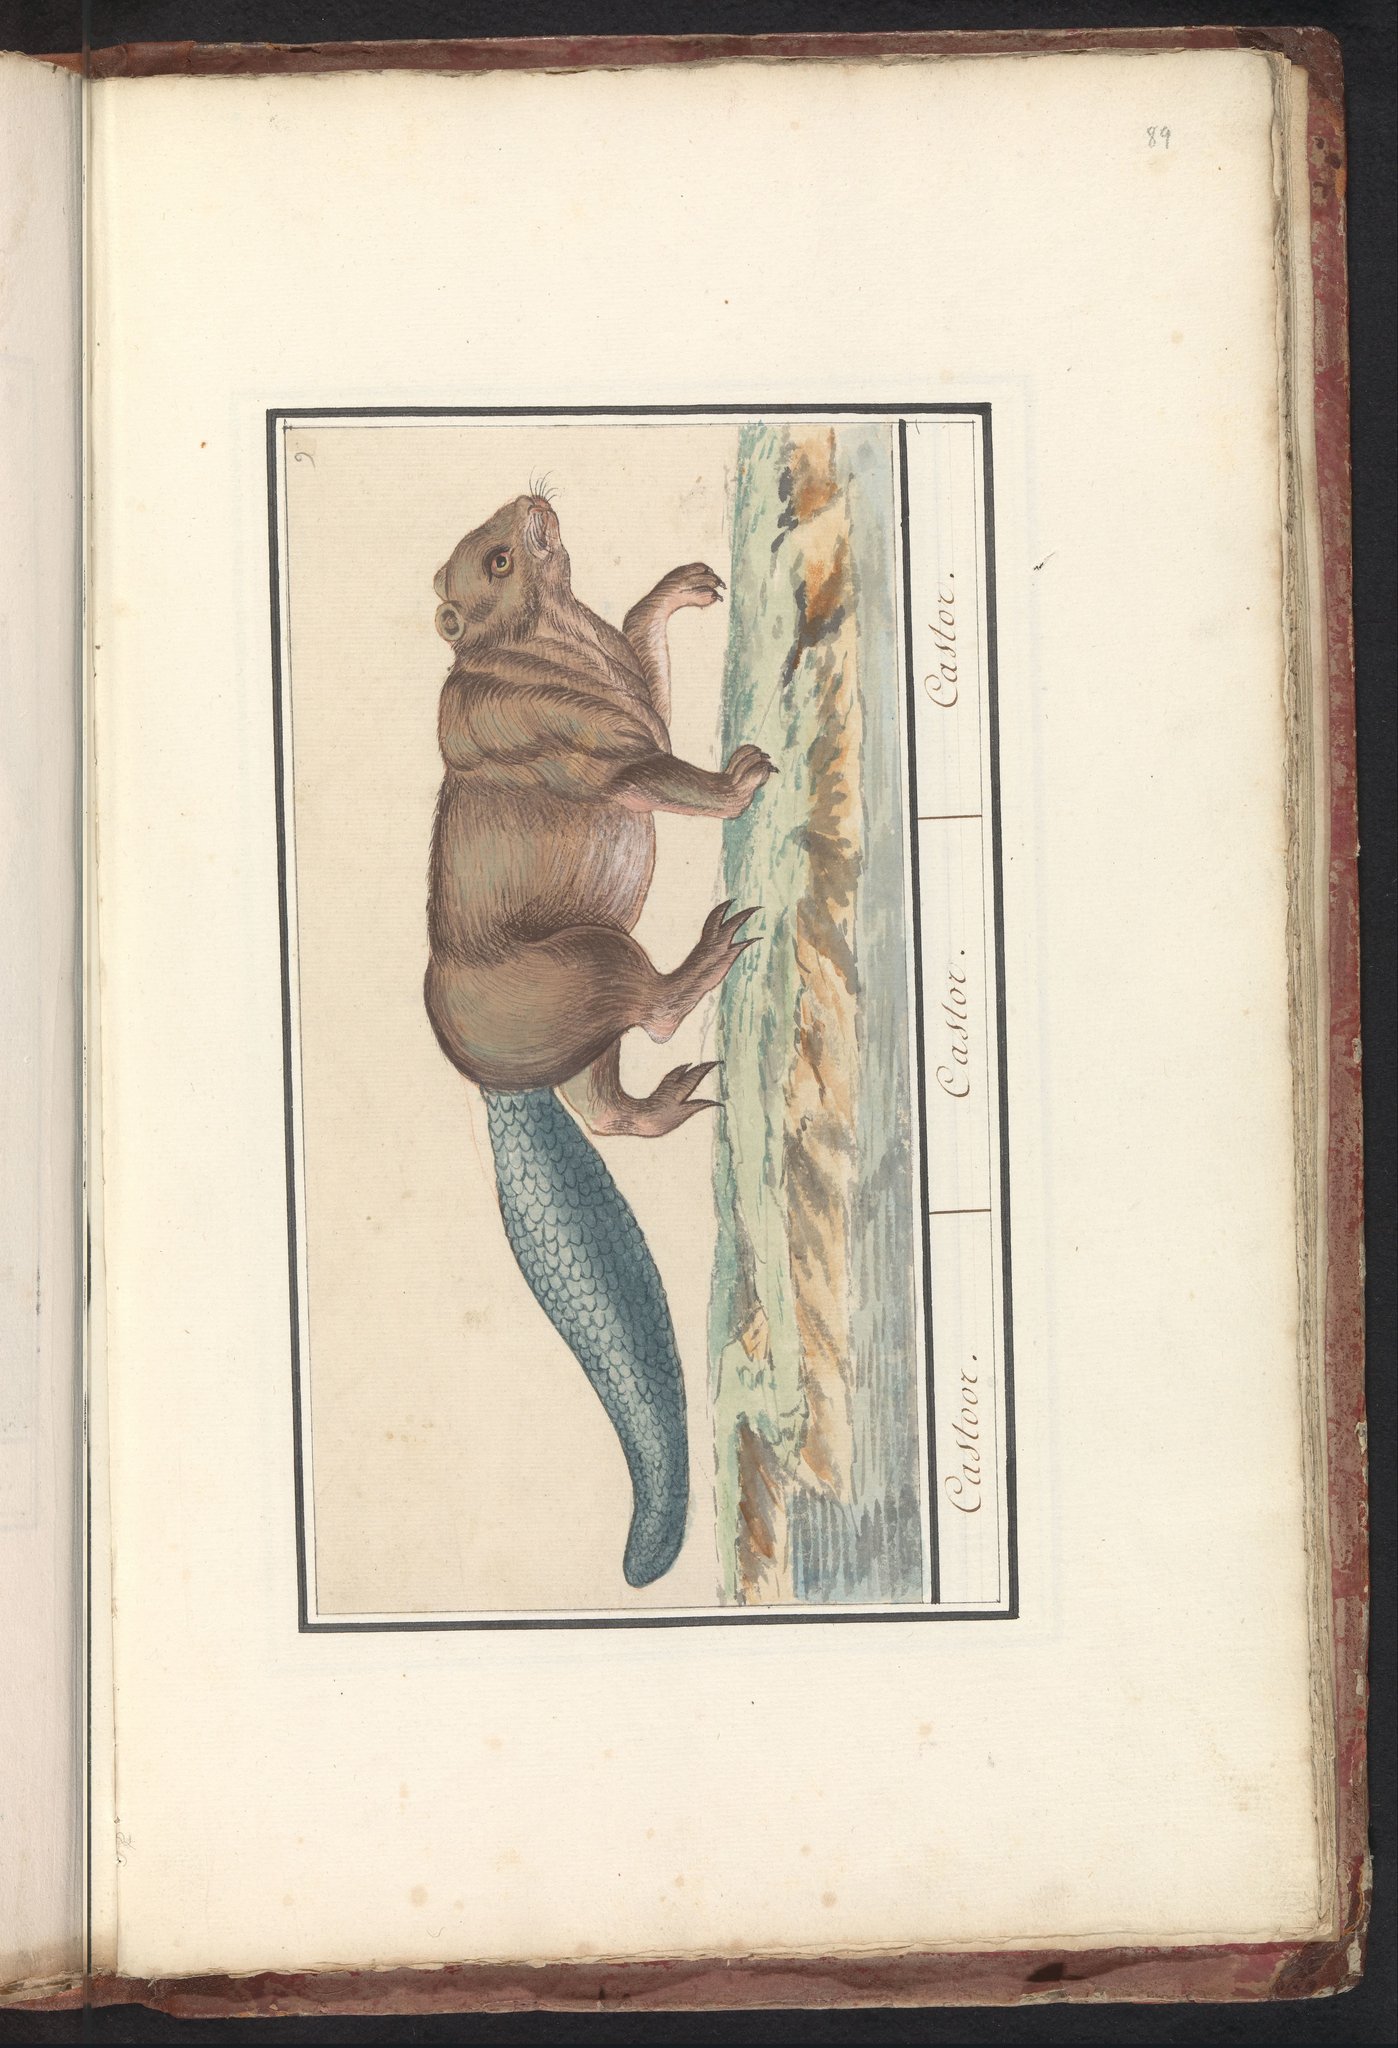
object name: drawing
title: Bever (Castor)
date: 1596-1610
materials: chalk, paint, paper, watercolor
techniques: brush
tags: rodents: beaver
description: Bever. Rechtsboven genummerd: 9. Onderdeel van het eerste album met tekeningen van viervoeters. Eerste van twaalf albums met tekeningen van dieren, vogels en planten bekend rond 1600, gemaakt in opdracht van keizer Rudolf II. Met toelichting in Nederlands, Latijn en Frans.